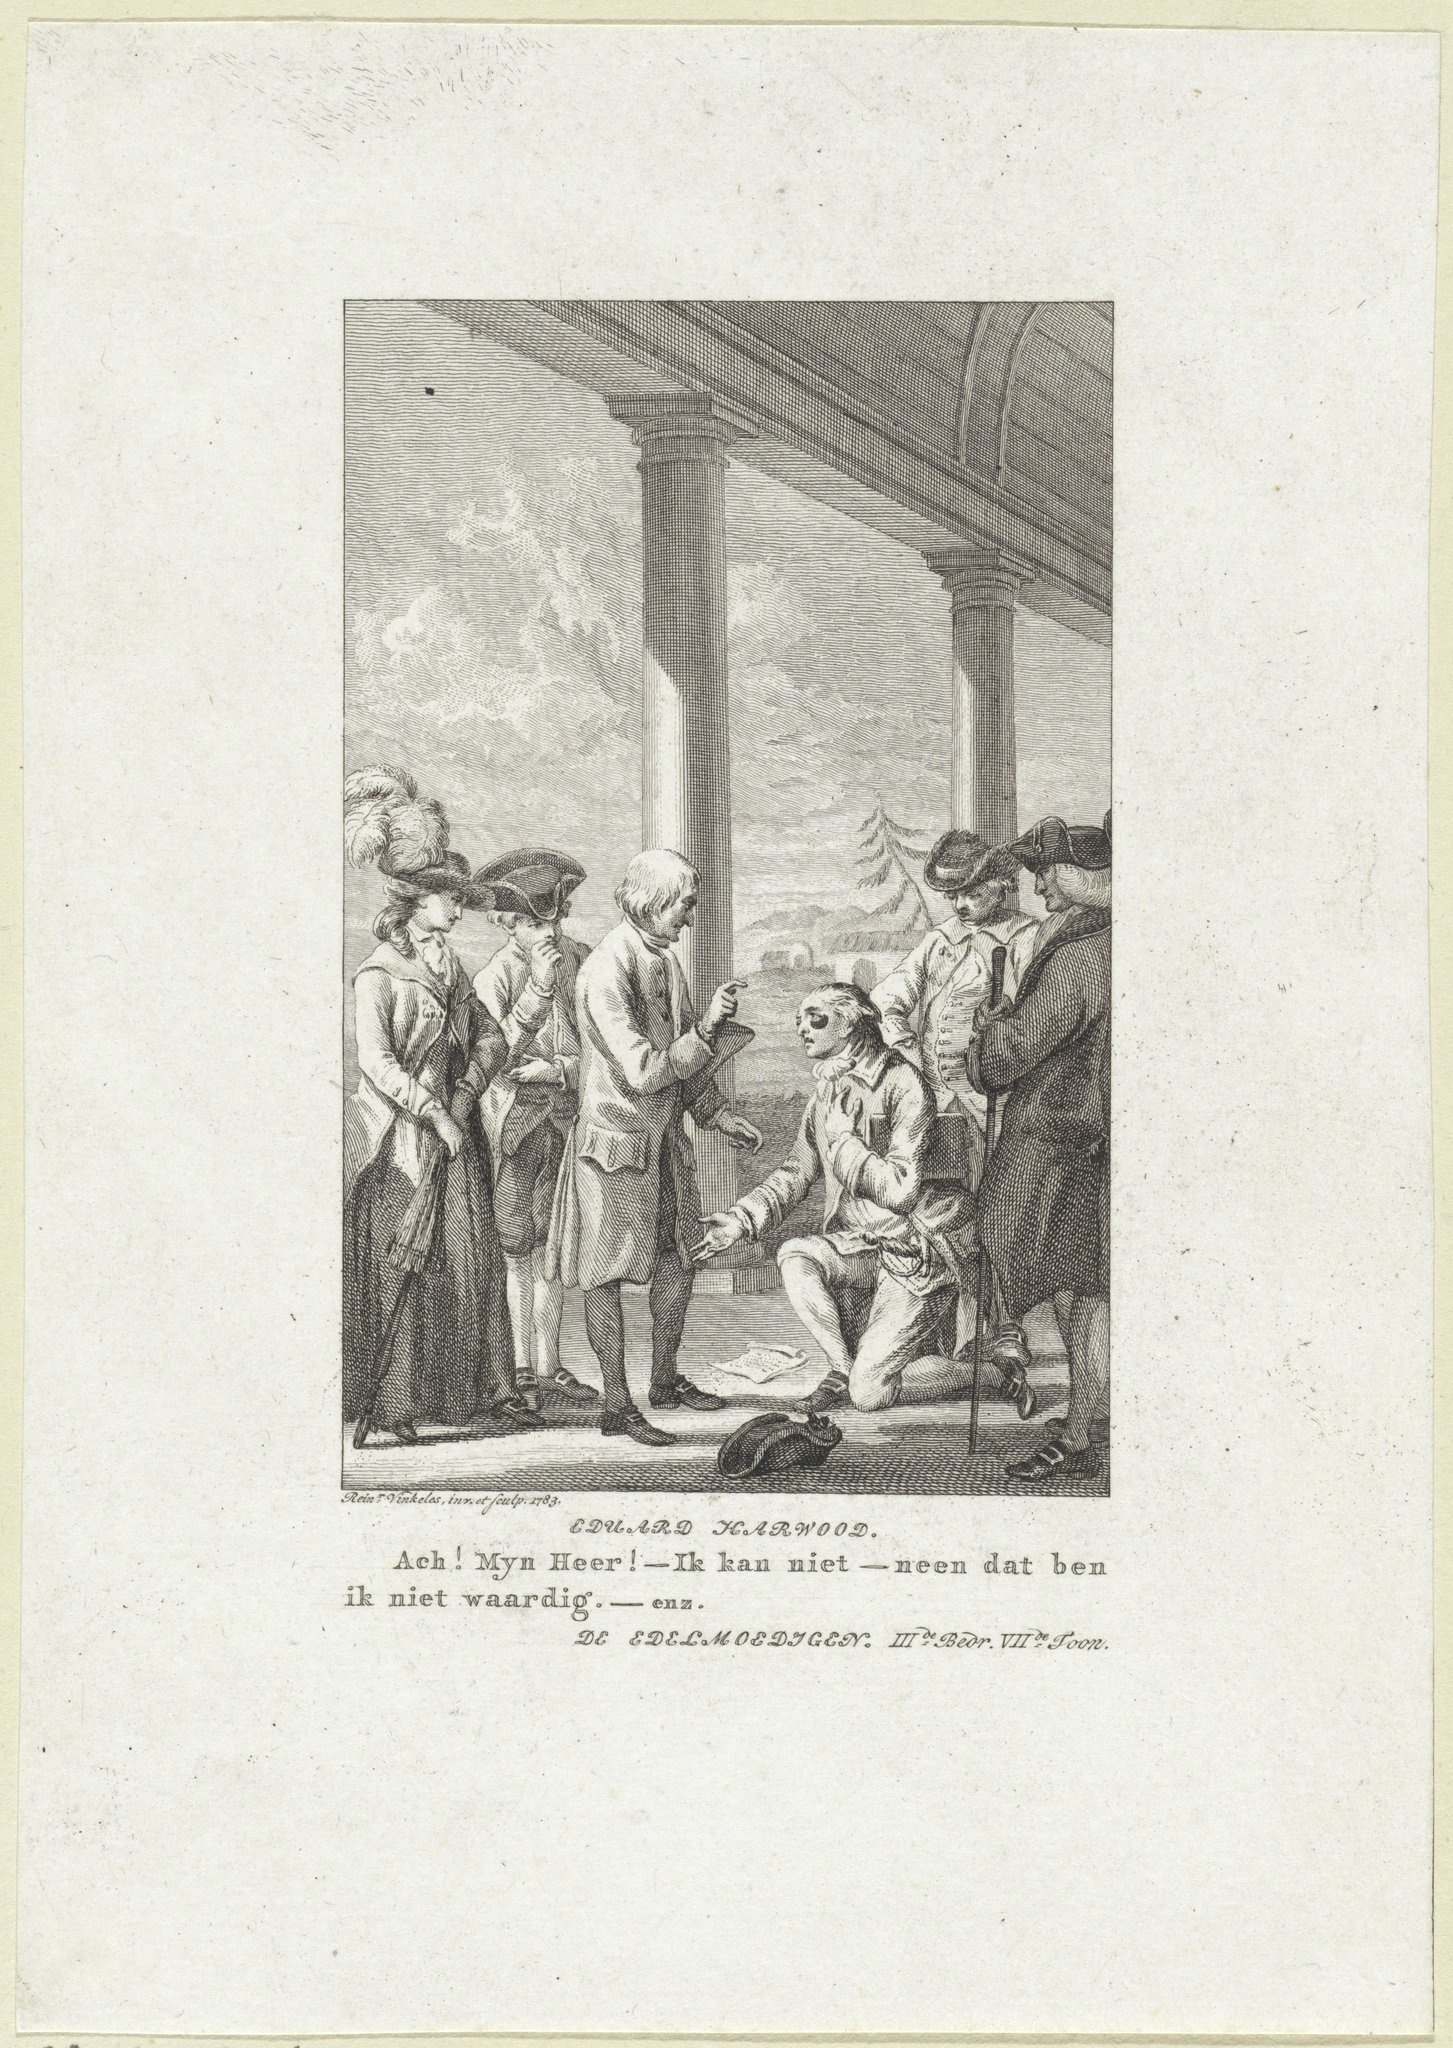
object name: print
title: Man met een blauw oog knielt voor een andere man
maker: reinier vinkeles (i)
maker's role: draughtsman, print maker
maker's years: 1741-1816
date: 1783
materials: paper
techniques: engraving, etching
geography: amsterdam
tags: relations between individual persons, landscapes, kneeling figure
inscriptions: collector's mark: Lugt 240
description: Deze prent is mogelijk gebruikt als illustratie in: Huguet Armand, François. De Edelmoedigen. Amsterdam: Pieter Meĳer, 1783.